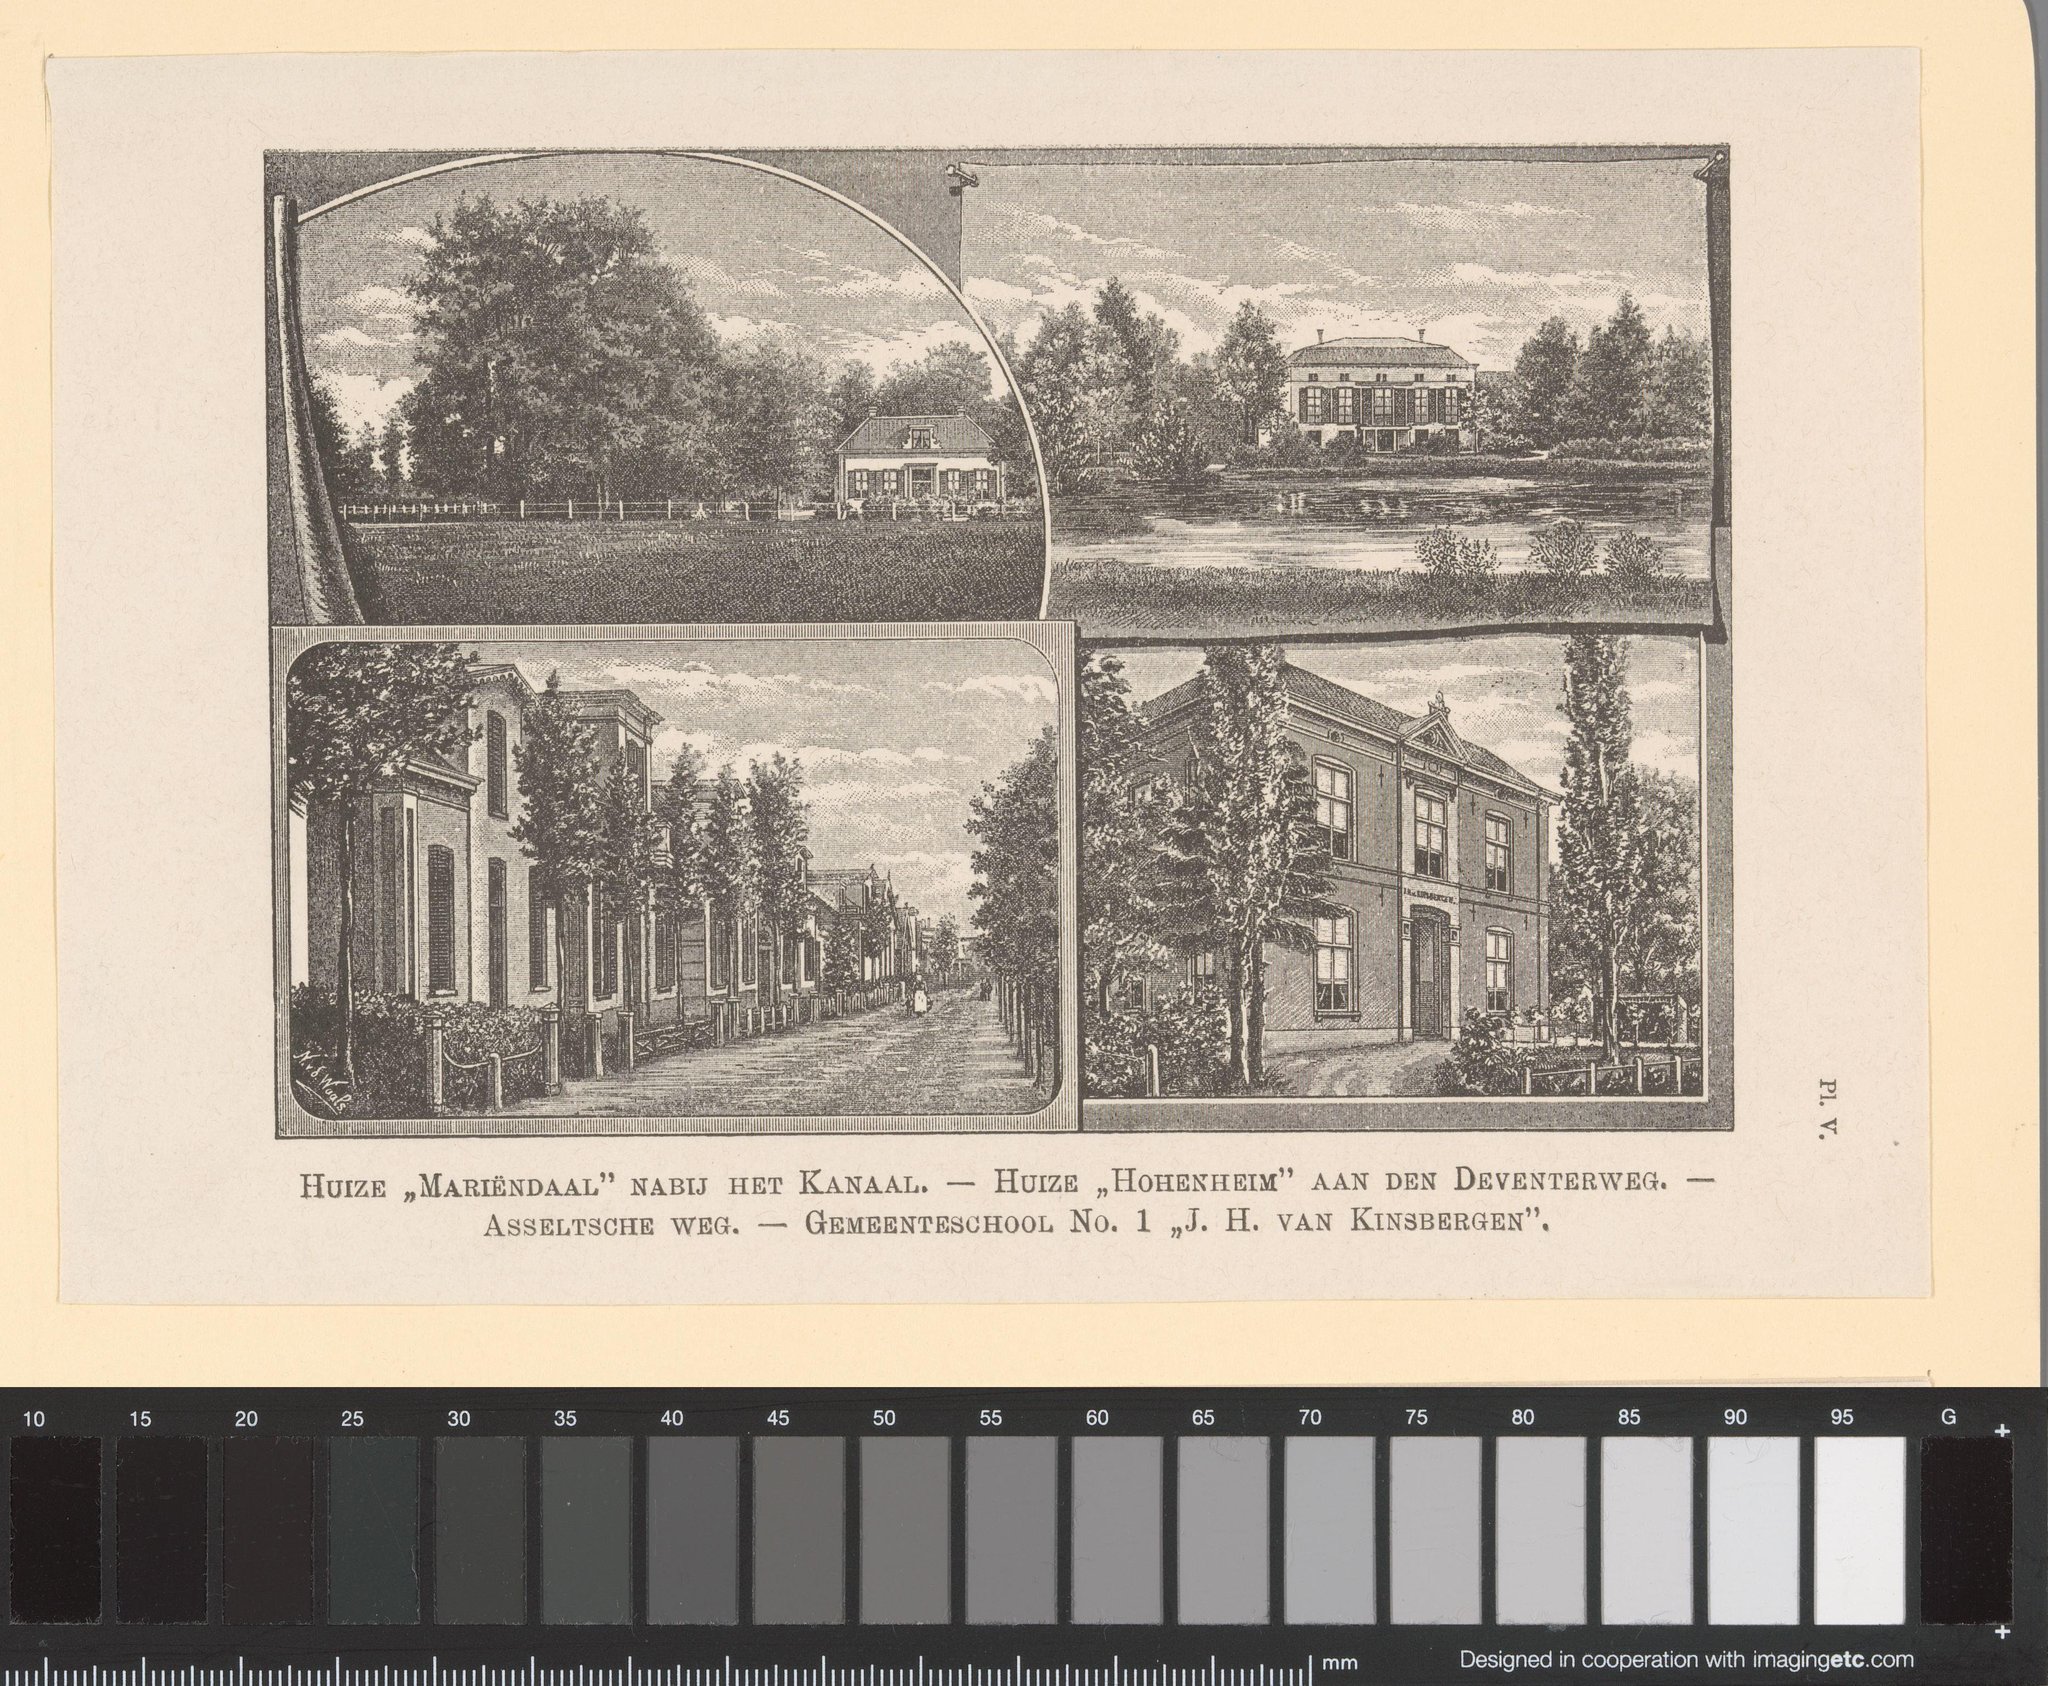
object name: photomechanical print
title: Gezichten in de omgeving van Apeldoorn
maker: noach van der waals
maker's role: print maker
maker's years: 1852-1930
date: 1890-1900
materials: paper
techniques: autotype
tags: city-view, and landscape with man-made constructions, rural housing, e.g. country-house, villa, cottage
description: Prent mogelijk uit: Gids voor Apeldoorn en omstreken. Apeldoorn: Vereeniging tot veraangenaming van het verblijf te Apeldoorn, [1891-1897].